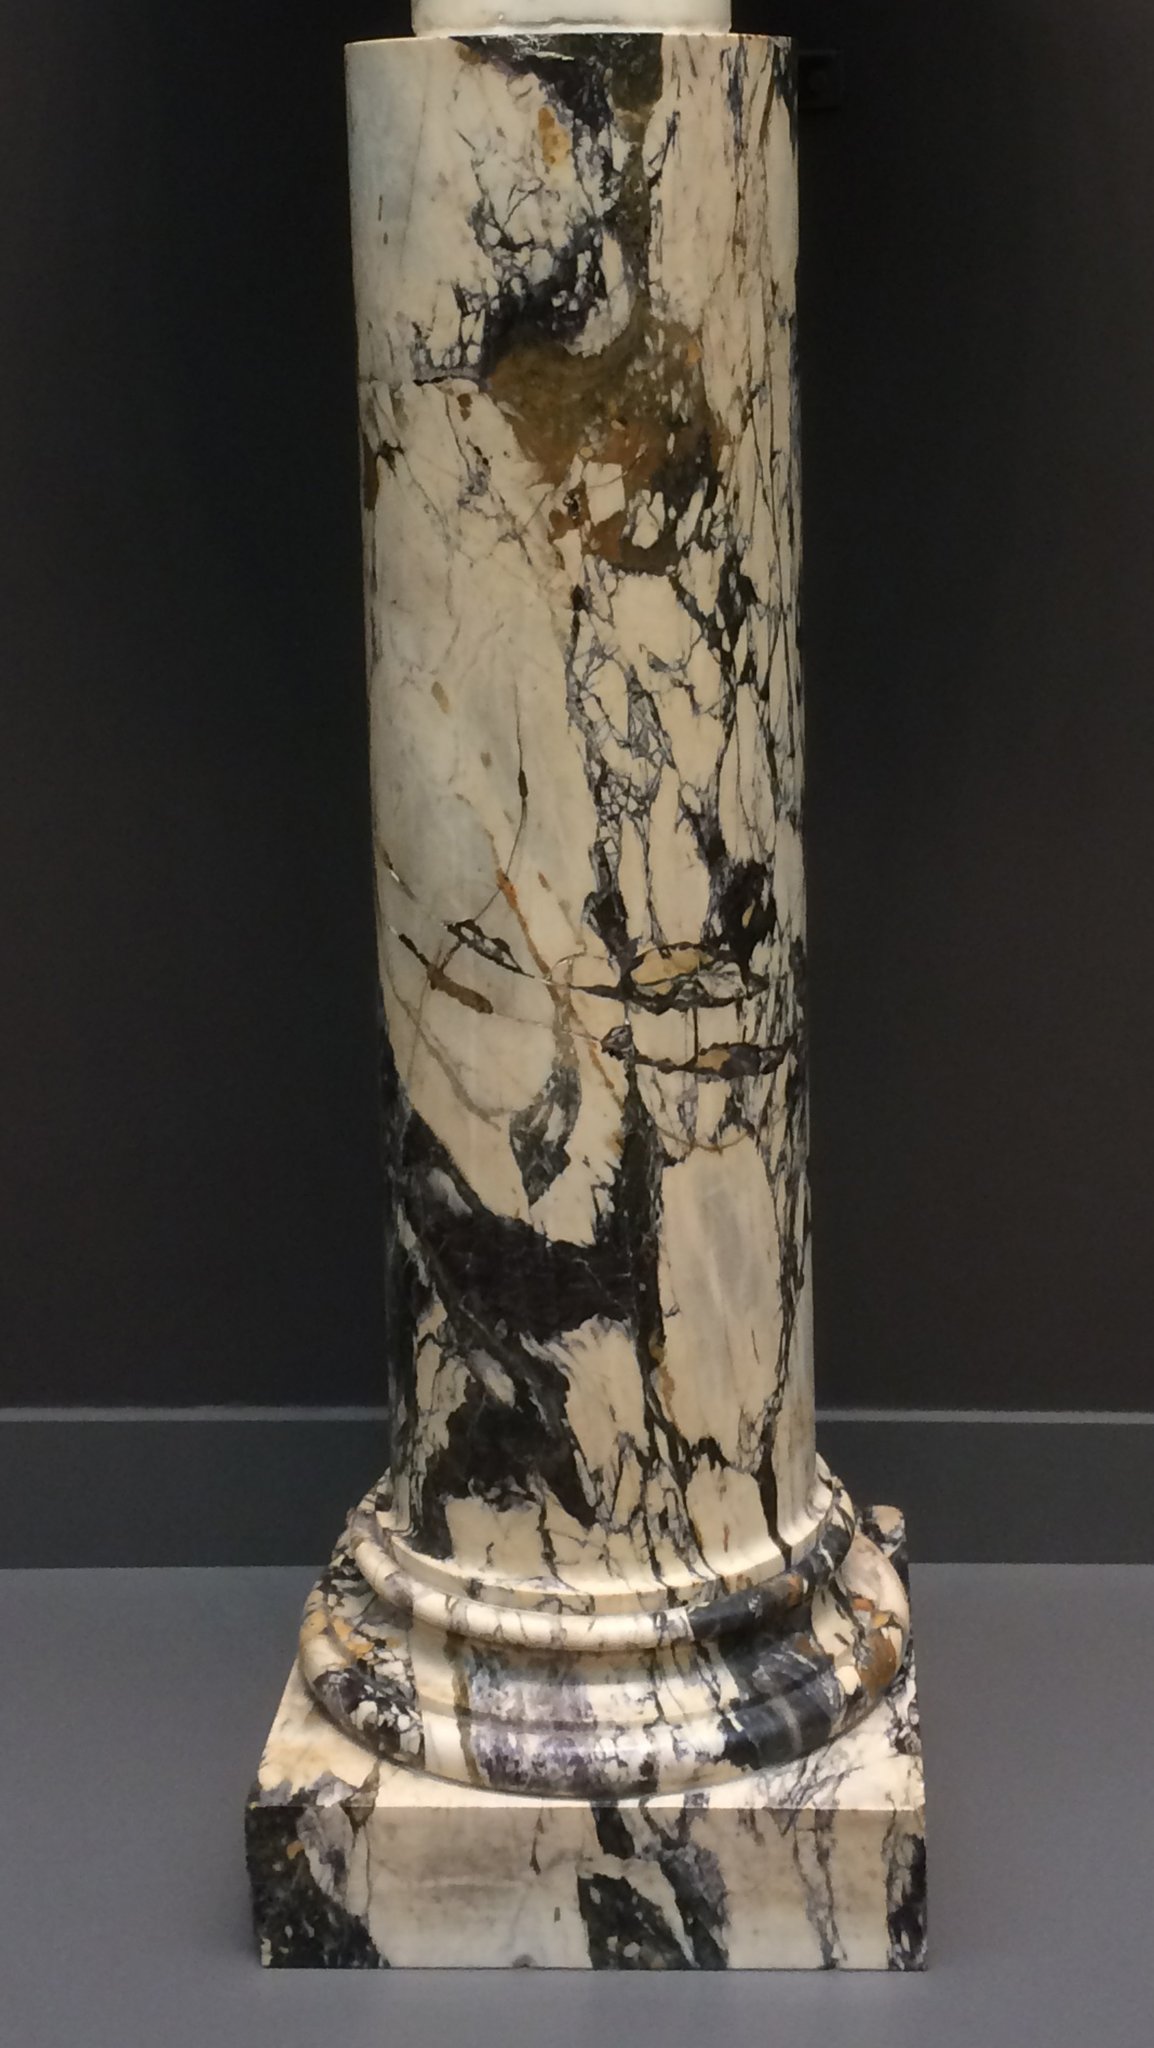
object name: pedestal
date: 1801-1900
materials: marble